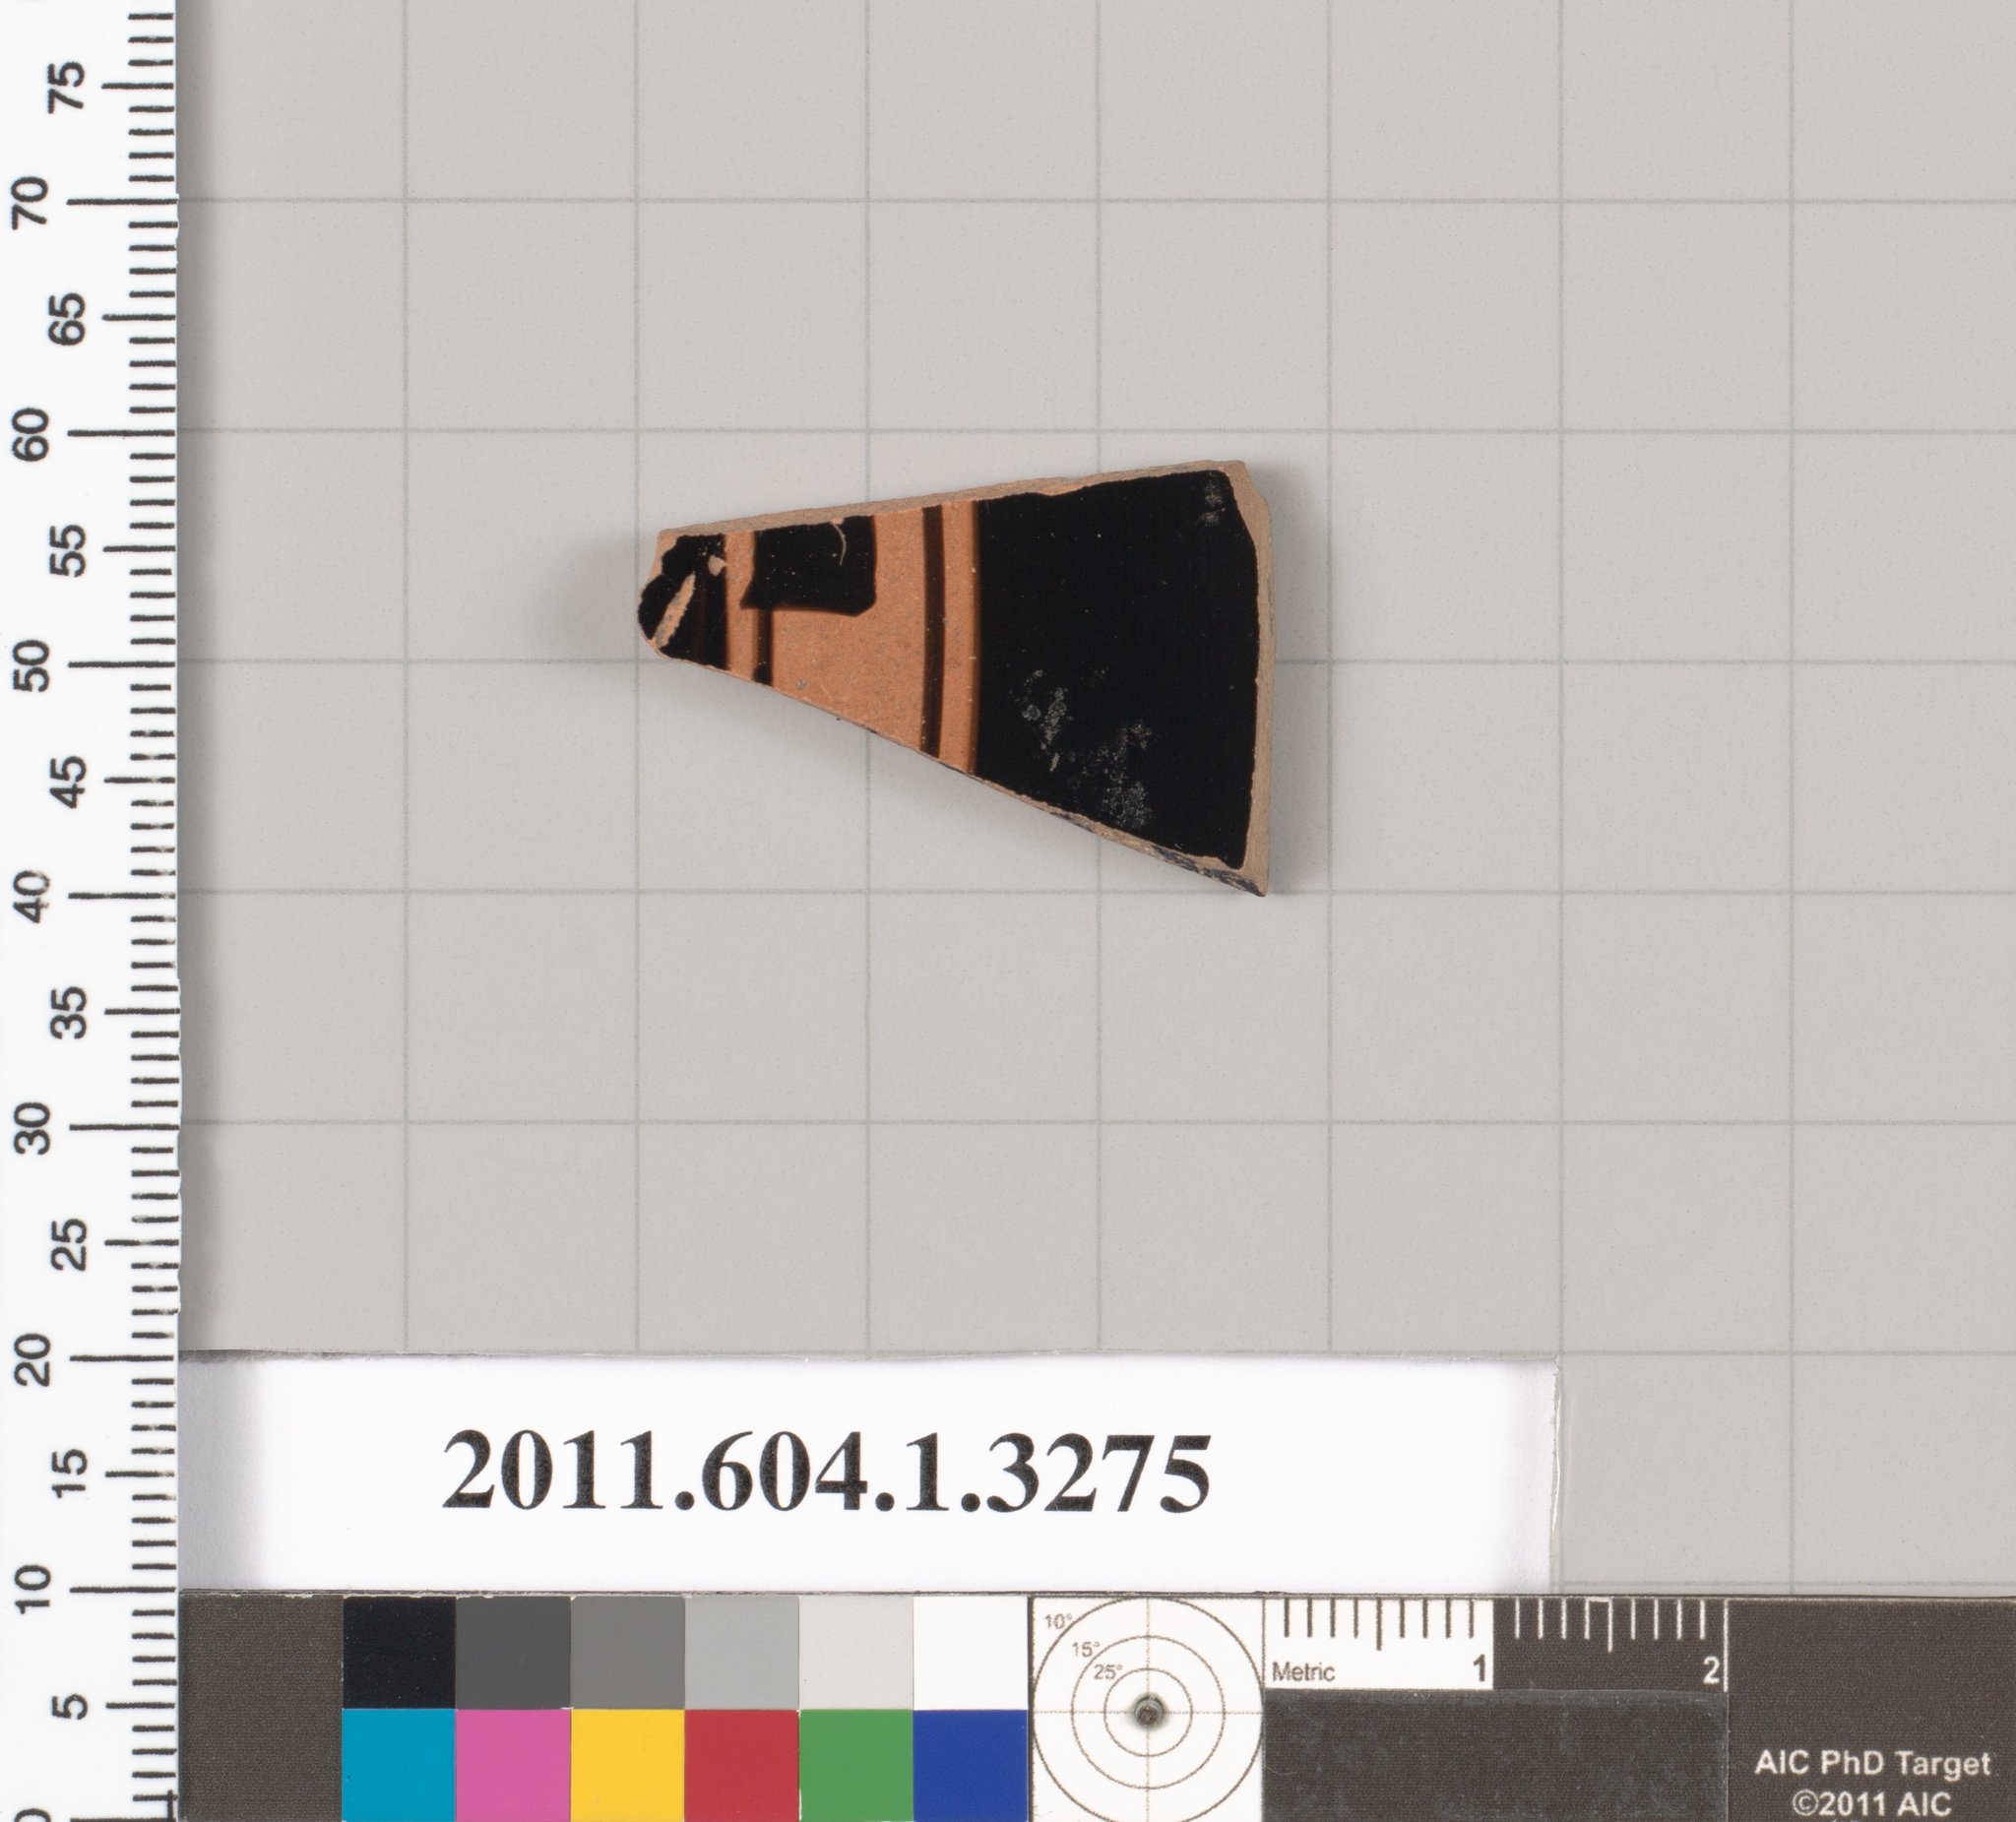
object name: kylix fragment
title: Terracotta fragment of a kylix (drinking cup)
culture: greek, attic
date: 500-490 BCE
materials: terracotta